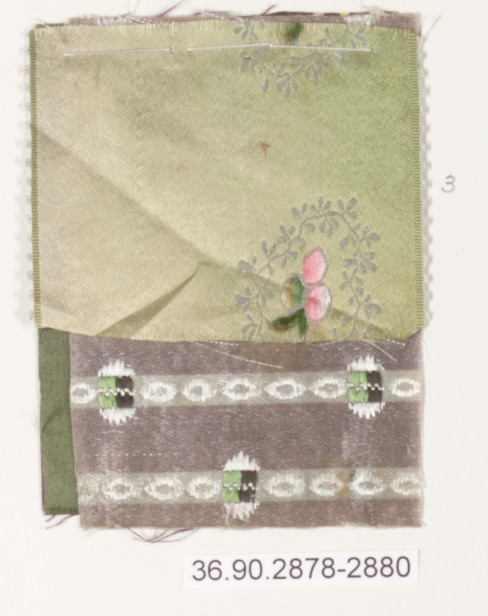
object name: piece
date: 1801-1900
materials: silk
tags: flowers